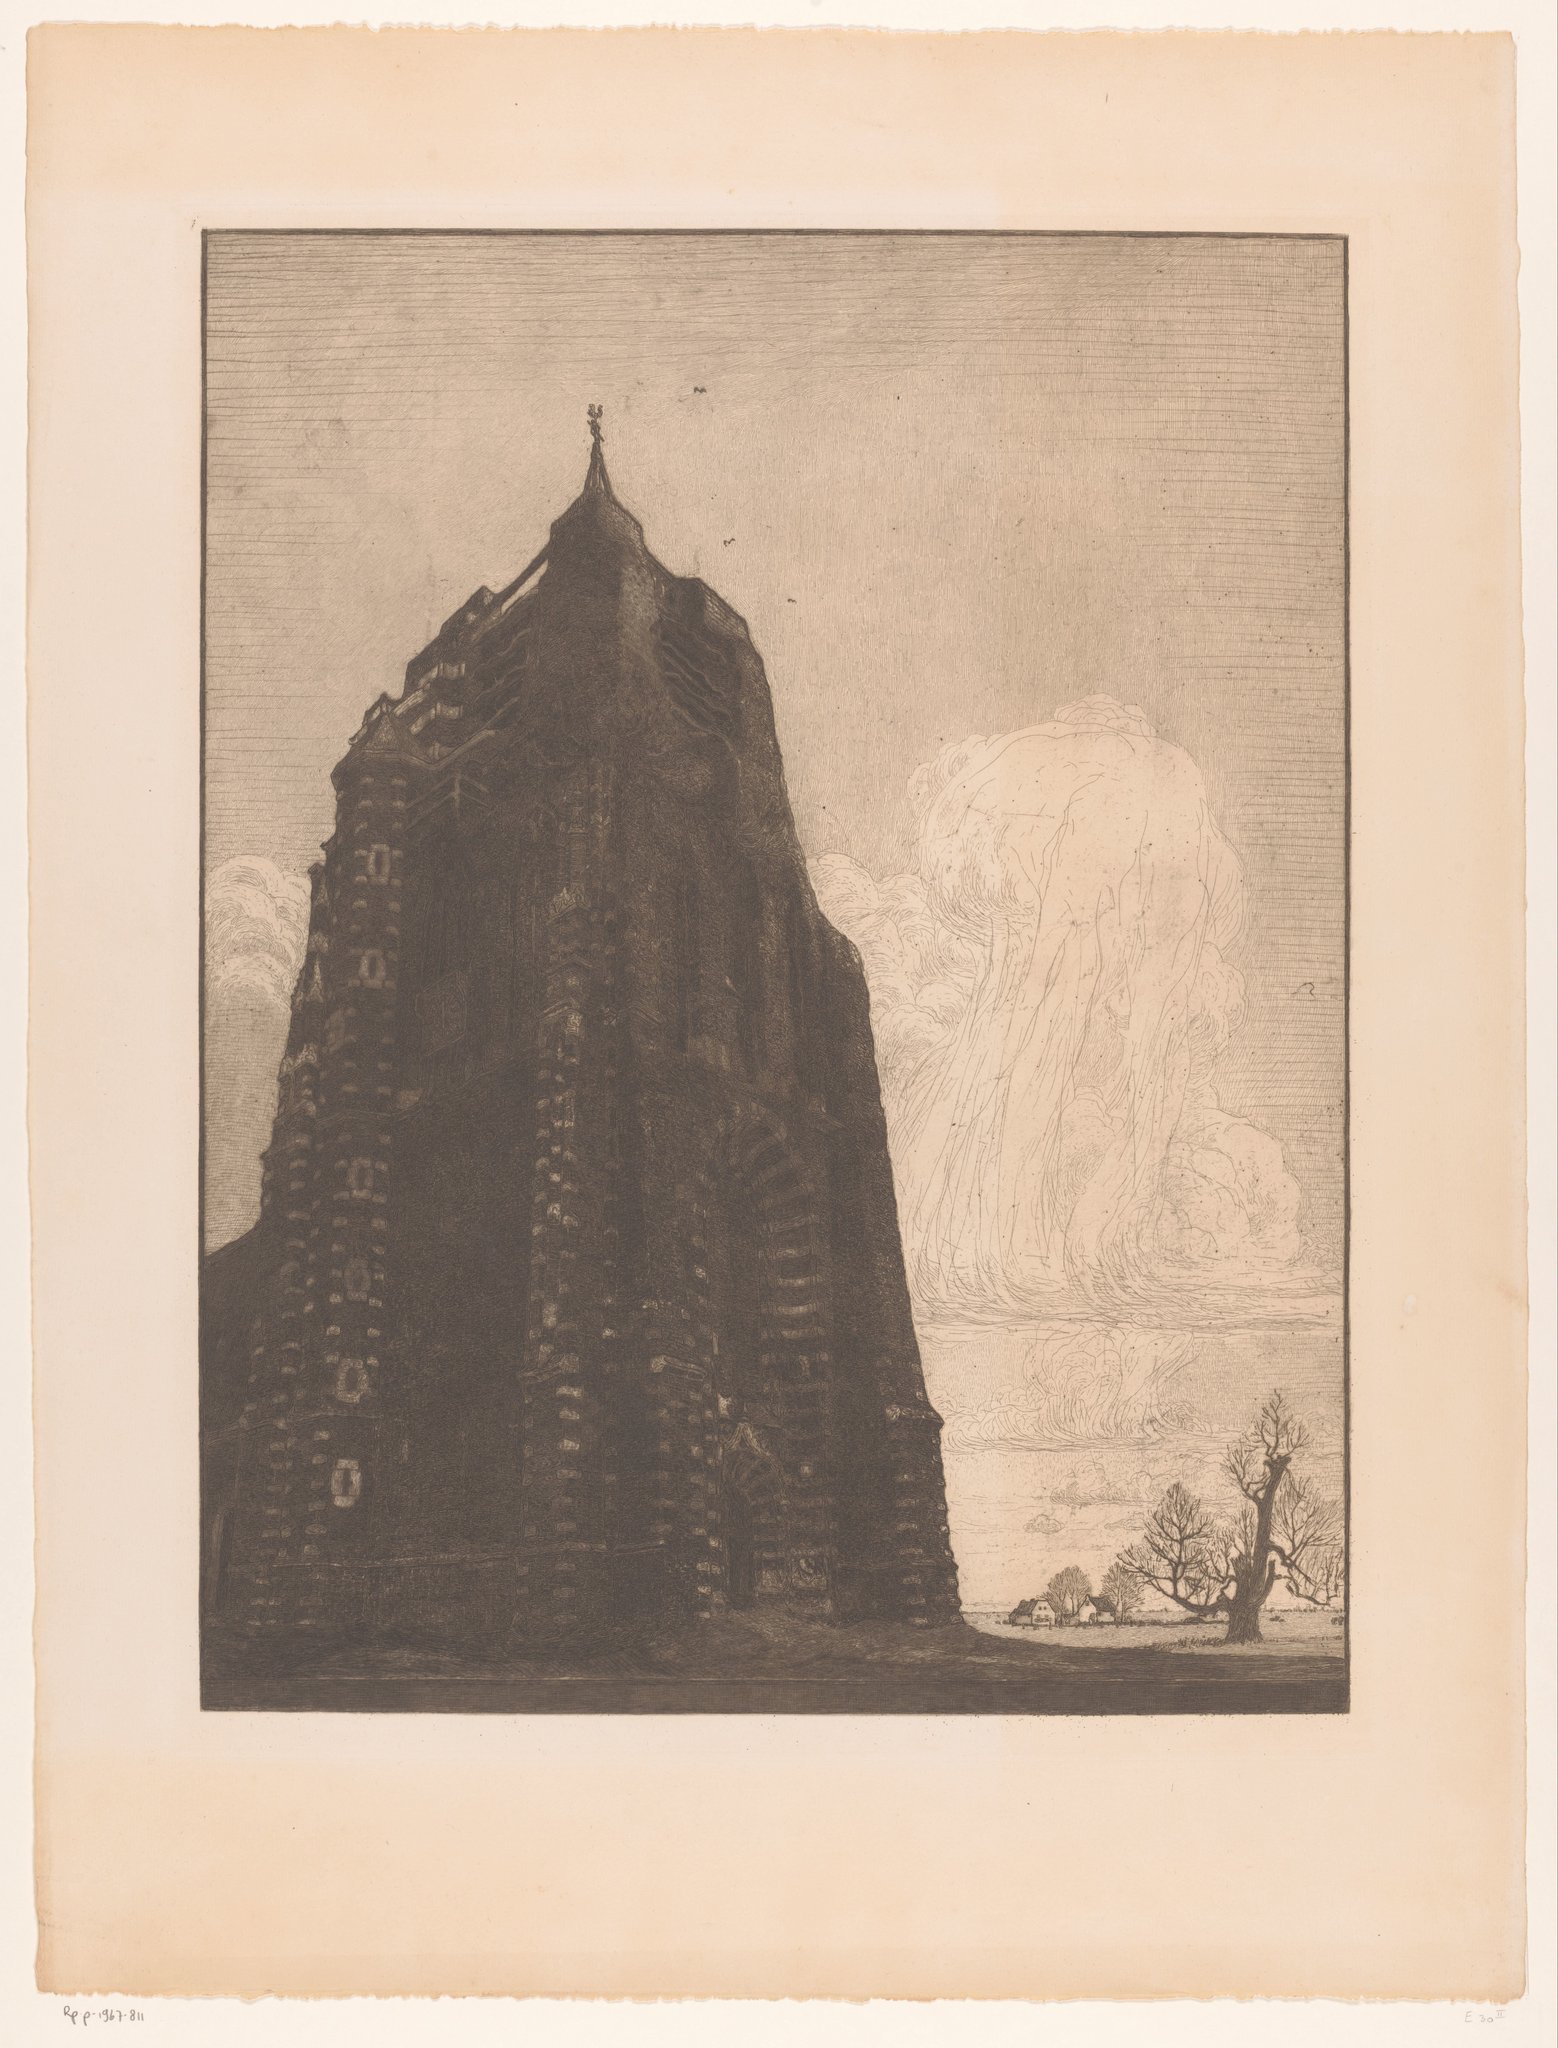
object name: print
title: De groote toren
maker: wijnand otto jan nieuwenkamp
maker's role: draughtsman, print maker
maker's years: 1874-1950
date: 1898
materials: paper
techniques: intaglio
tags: parts of church exterior and annexes: tower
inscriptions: collector's mark: Lugt 2228, collector's mark: Lugt 2760